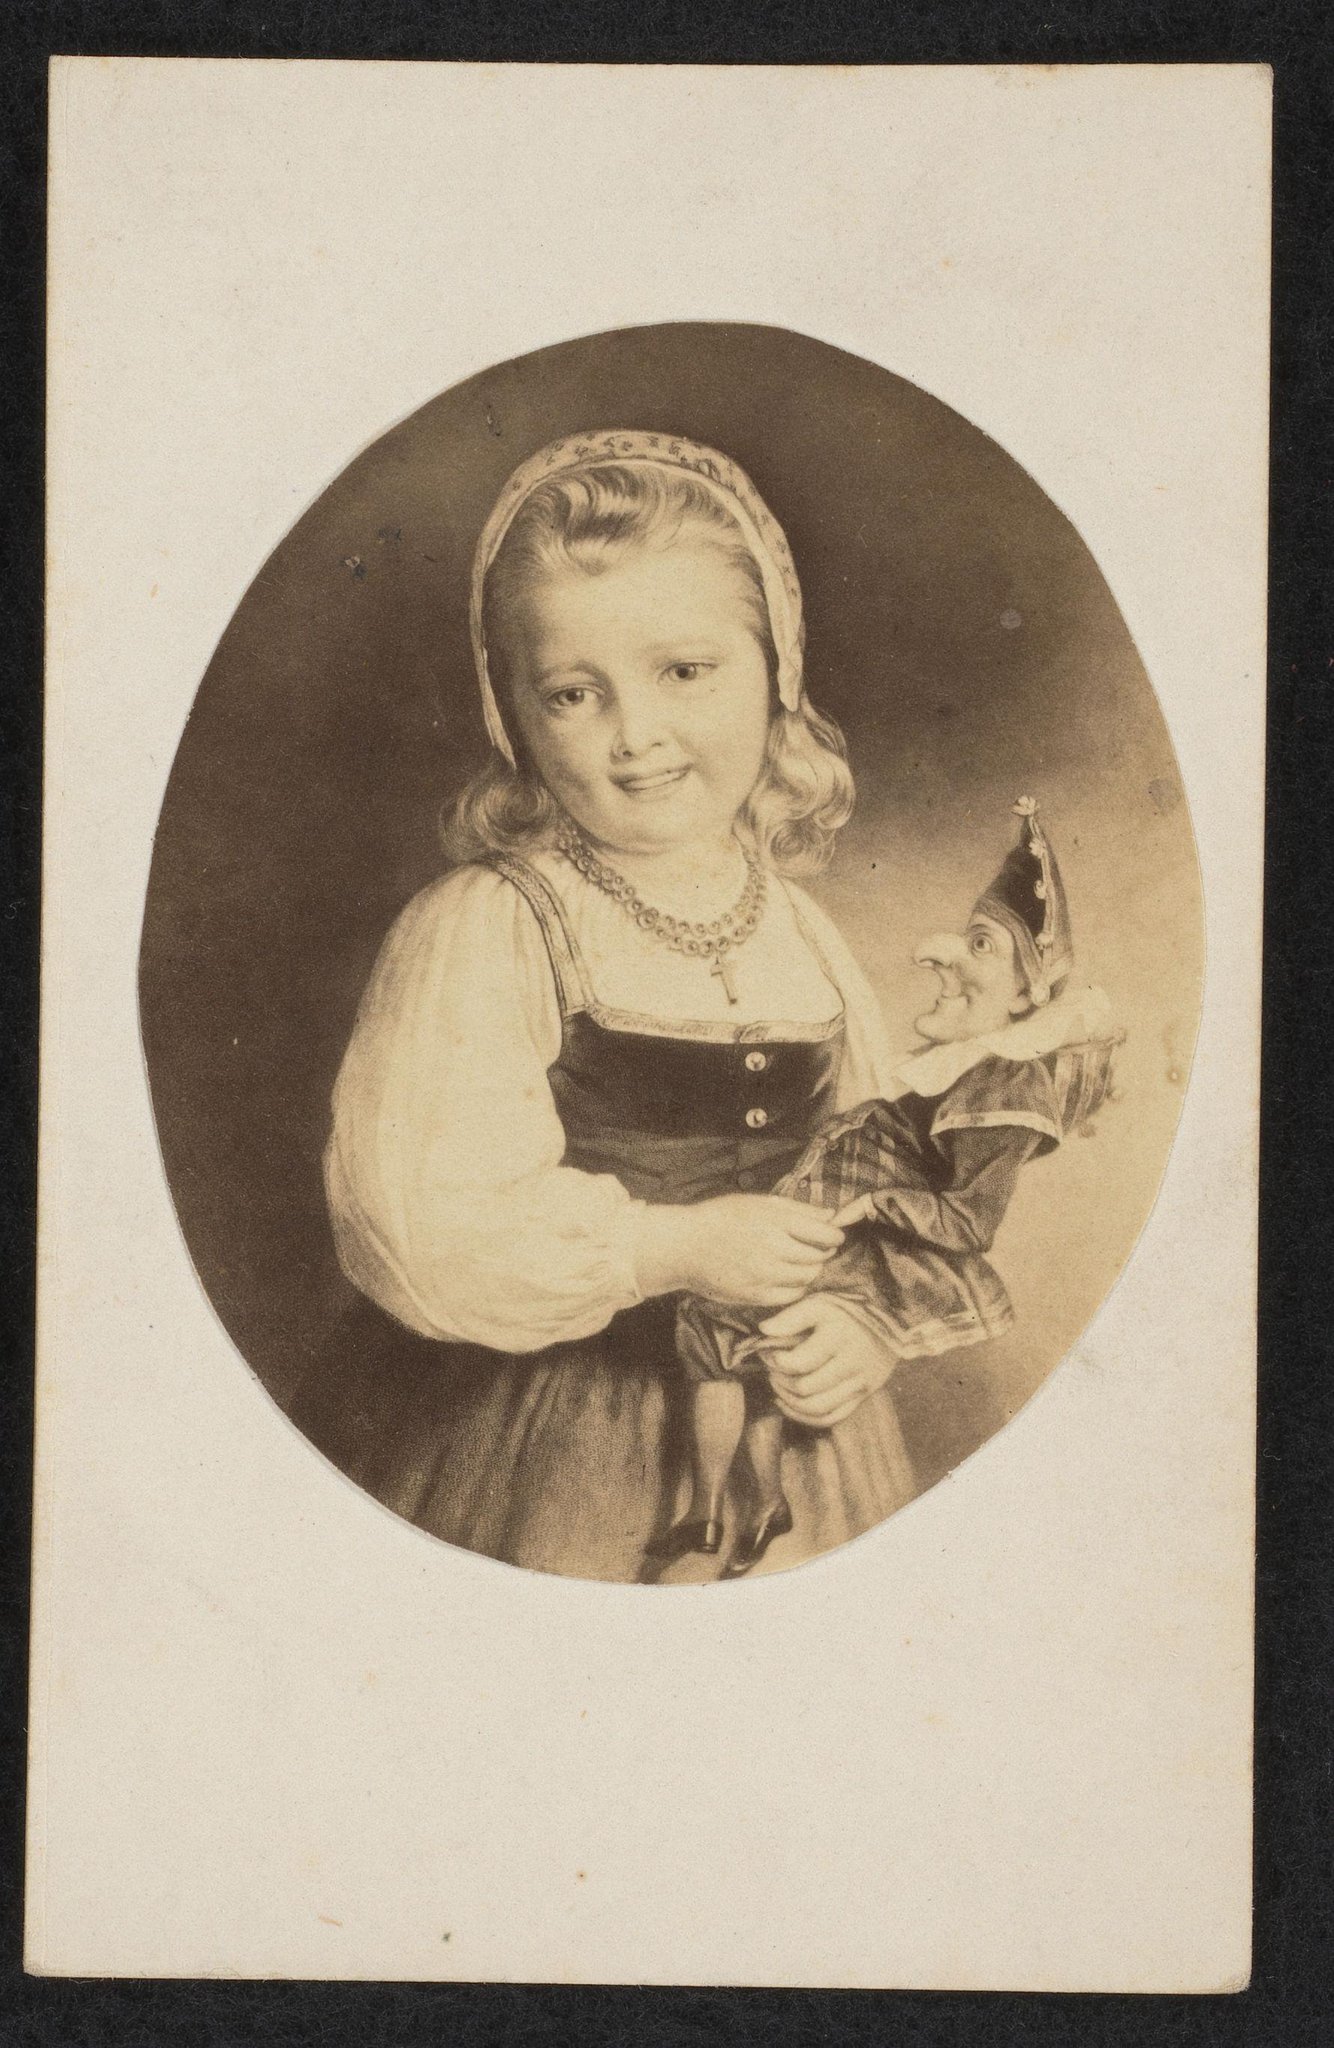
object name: photograph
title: Fotoreproductie van een schilderij met lachend meisje met narrenpop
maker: Anonymous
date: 1860-1900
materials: cardboard, photographic support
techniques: albumen print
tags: girl (child between toddler and youth), (playing with) dolls